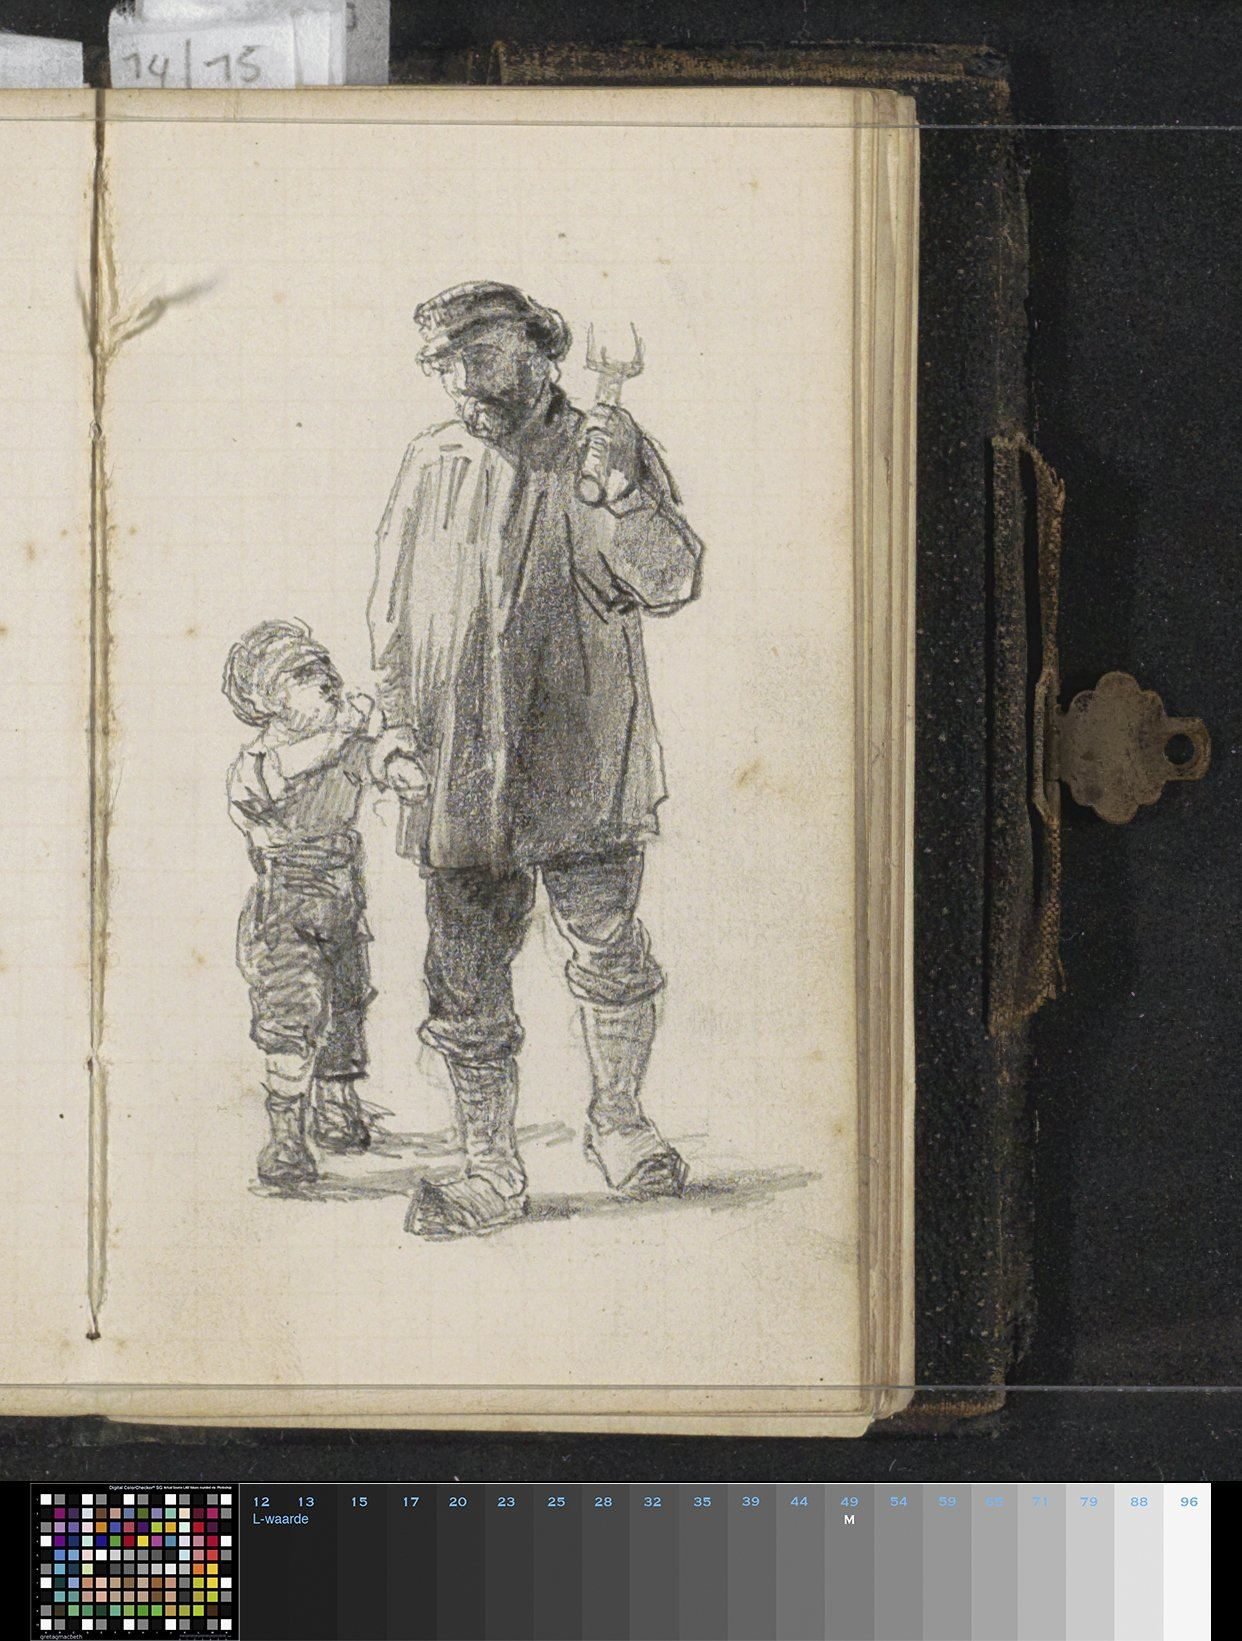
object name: sketchbook leaf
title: Jongen en boer met een stuk landbouwgereedschap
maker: jan willem van borselen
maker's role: draughtsman, print maker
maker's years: 1825-1892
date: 1868-1887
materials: pencil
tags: boy (child between toddler and youth), farmers, agricultural implements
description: De man draagt het gereedschap, vermoedelijk een handcultivator, op de schouder. Blad 11 recto uit een schetsboek met 51 bladen.